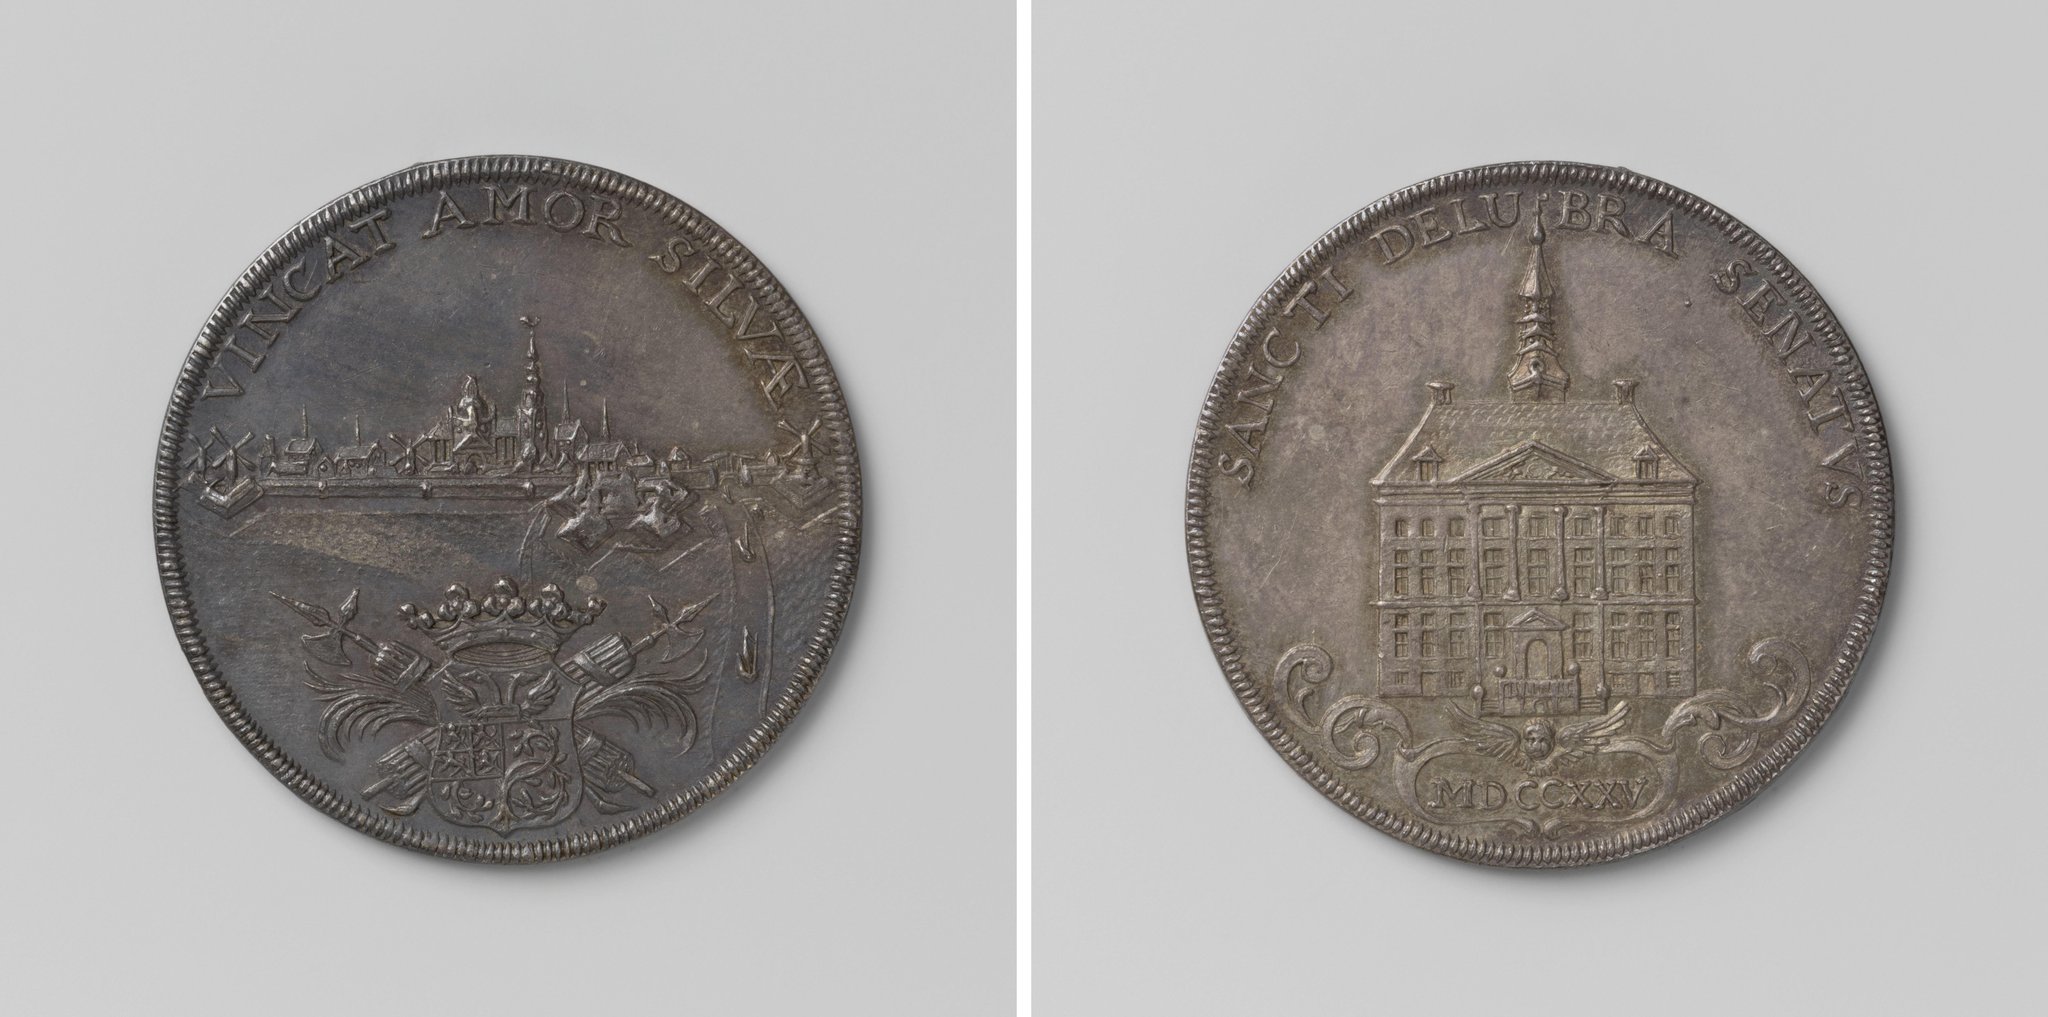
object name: council medal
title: Vroedschapspenning van de stad 's-Hertogenbosch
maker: theodorus casparus van berckel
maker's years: 1680-1734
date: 1725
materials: silver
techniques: striking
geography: den bosch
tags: den bosch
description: Zilveren penning. Voorzijde: gezicht op stad vanaf de noordzijde en de Dieze met twee scheepjes; op voorgrond: gekroond wapenschild op twee gekruiste roedebundels met bijlen en twee palmtakken binnen omschrift. Keerzijde: stadhuis boven cartouche met jaartal onder gevleugeld engelenkopje binnen omschrift.